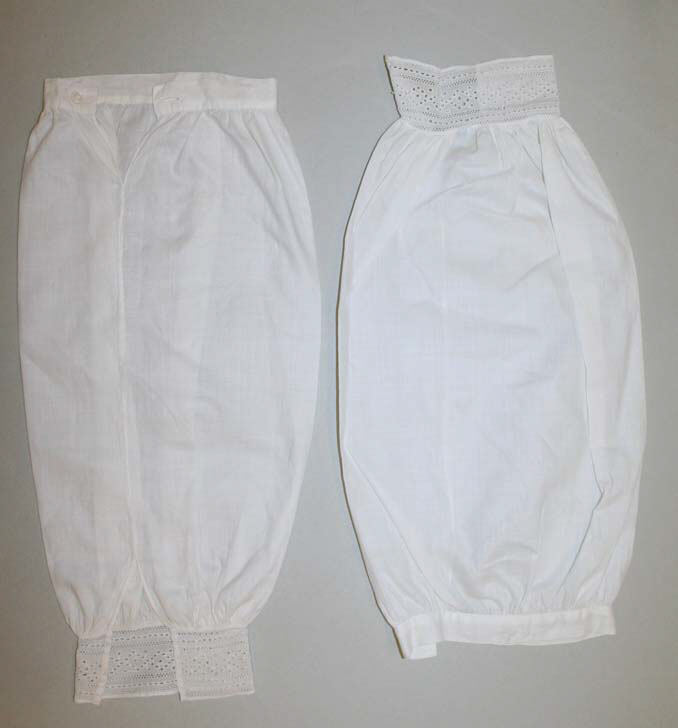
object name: undersleeves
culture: american or european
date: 1860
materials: linen